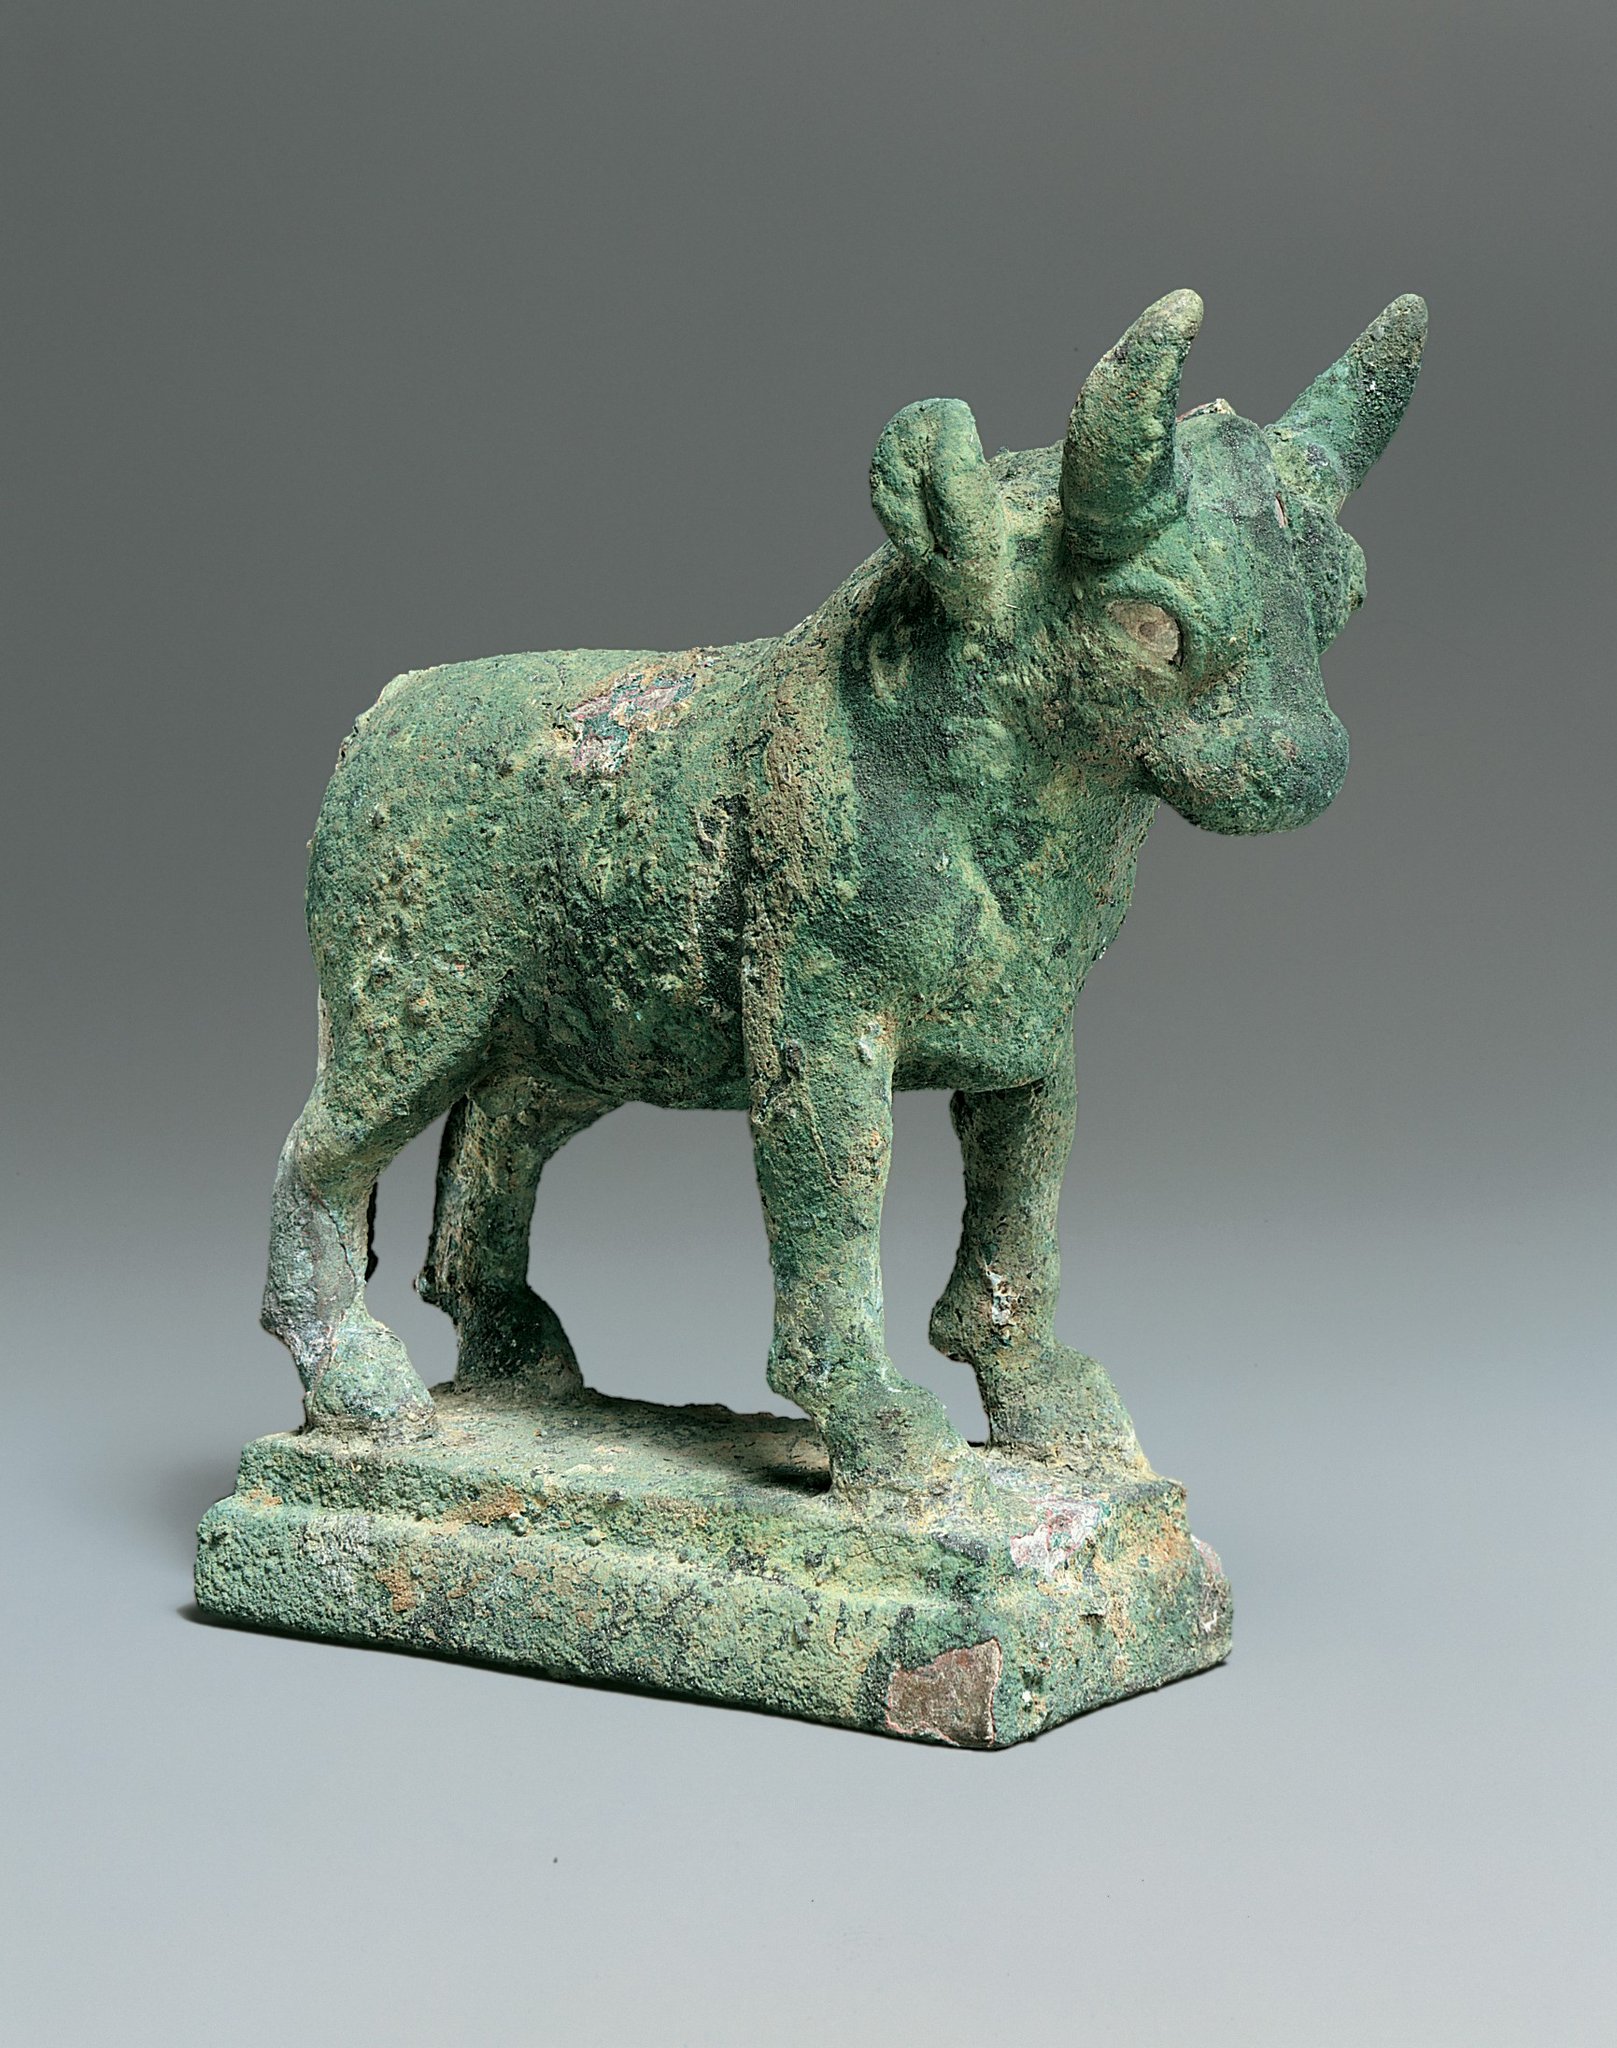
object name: sculpture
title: Standing bull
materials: copper alloy, shell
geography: southwestern arabia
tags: bulls